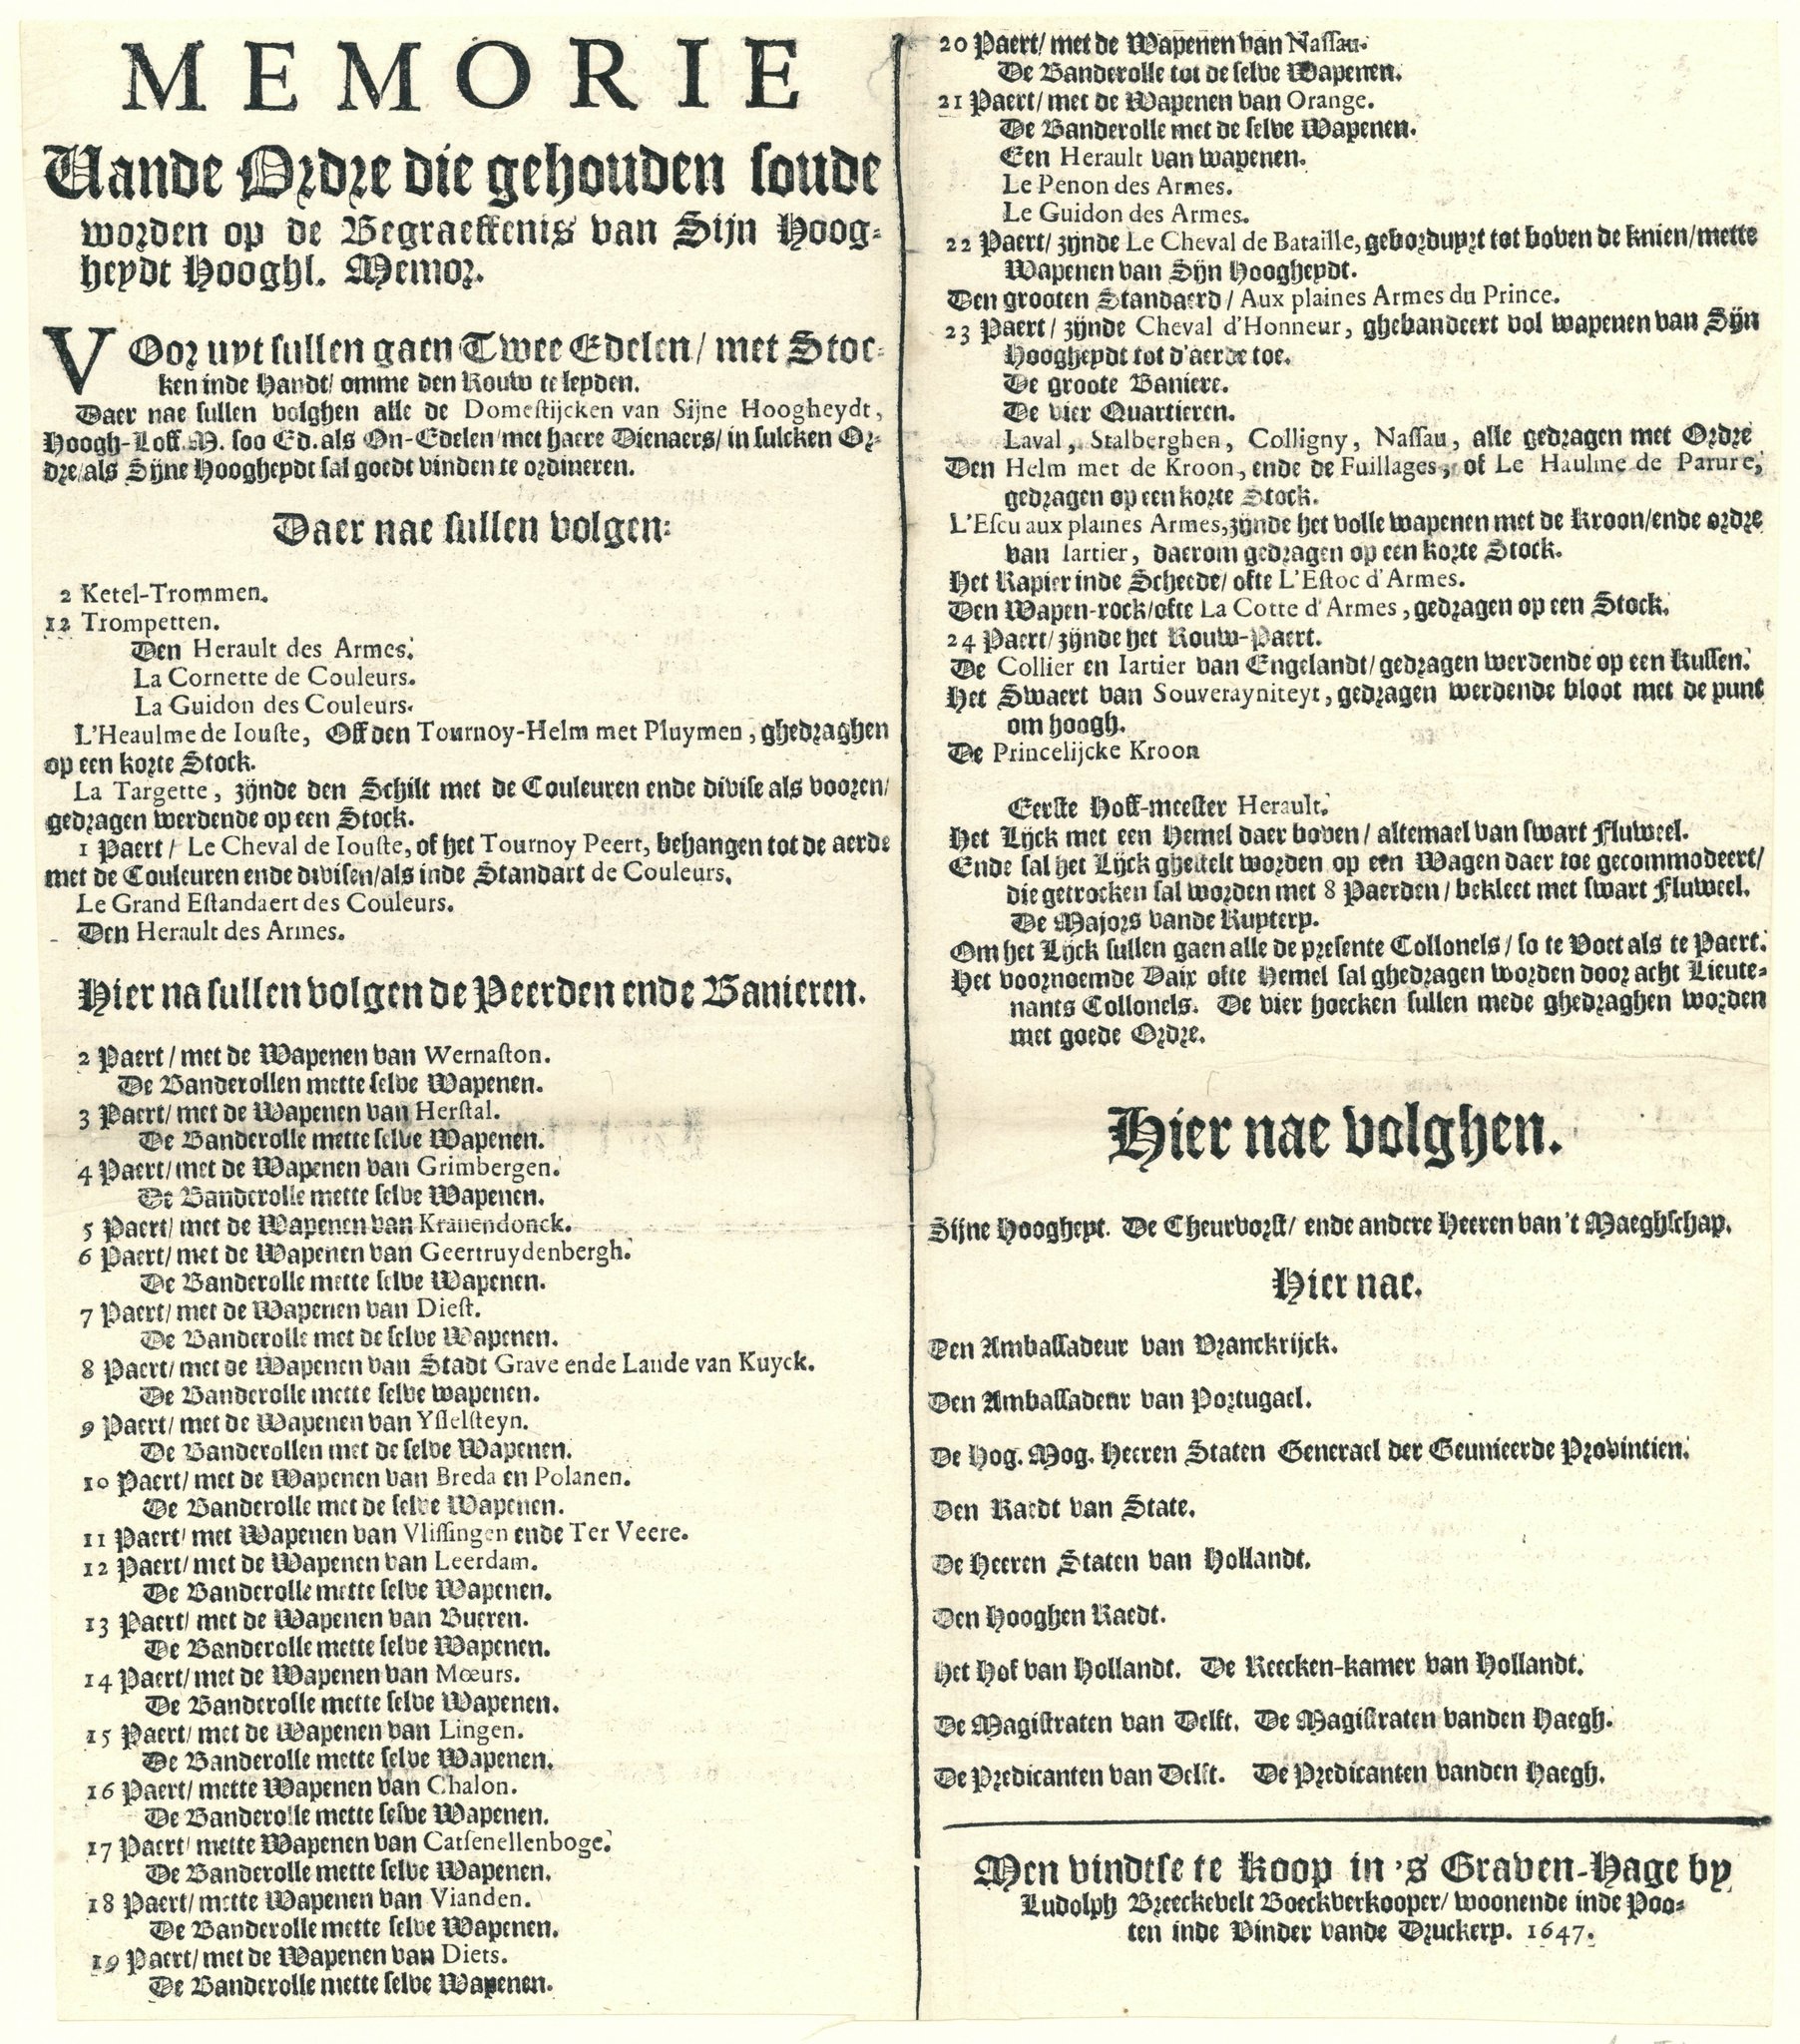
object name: programma, programmaboekje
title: Programma van de begrafenis van Frederik Hendrik, 1647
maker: ludolph breeckevelt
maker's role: publisher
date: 1647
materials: paper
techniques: letterpress printing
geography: the hague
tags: delft, the hague, frederick henry (prince of orange)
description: Blad met een gedrukte tekst in twee kolommen met een gedetailleerde beschrijving van de lijkstatie van Frederik Hendrik die op 10 mei 1647 te 's-Gravenhage gehouden zal worden. Exemplaar van de druk met het jaartal.